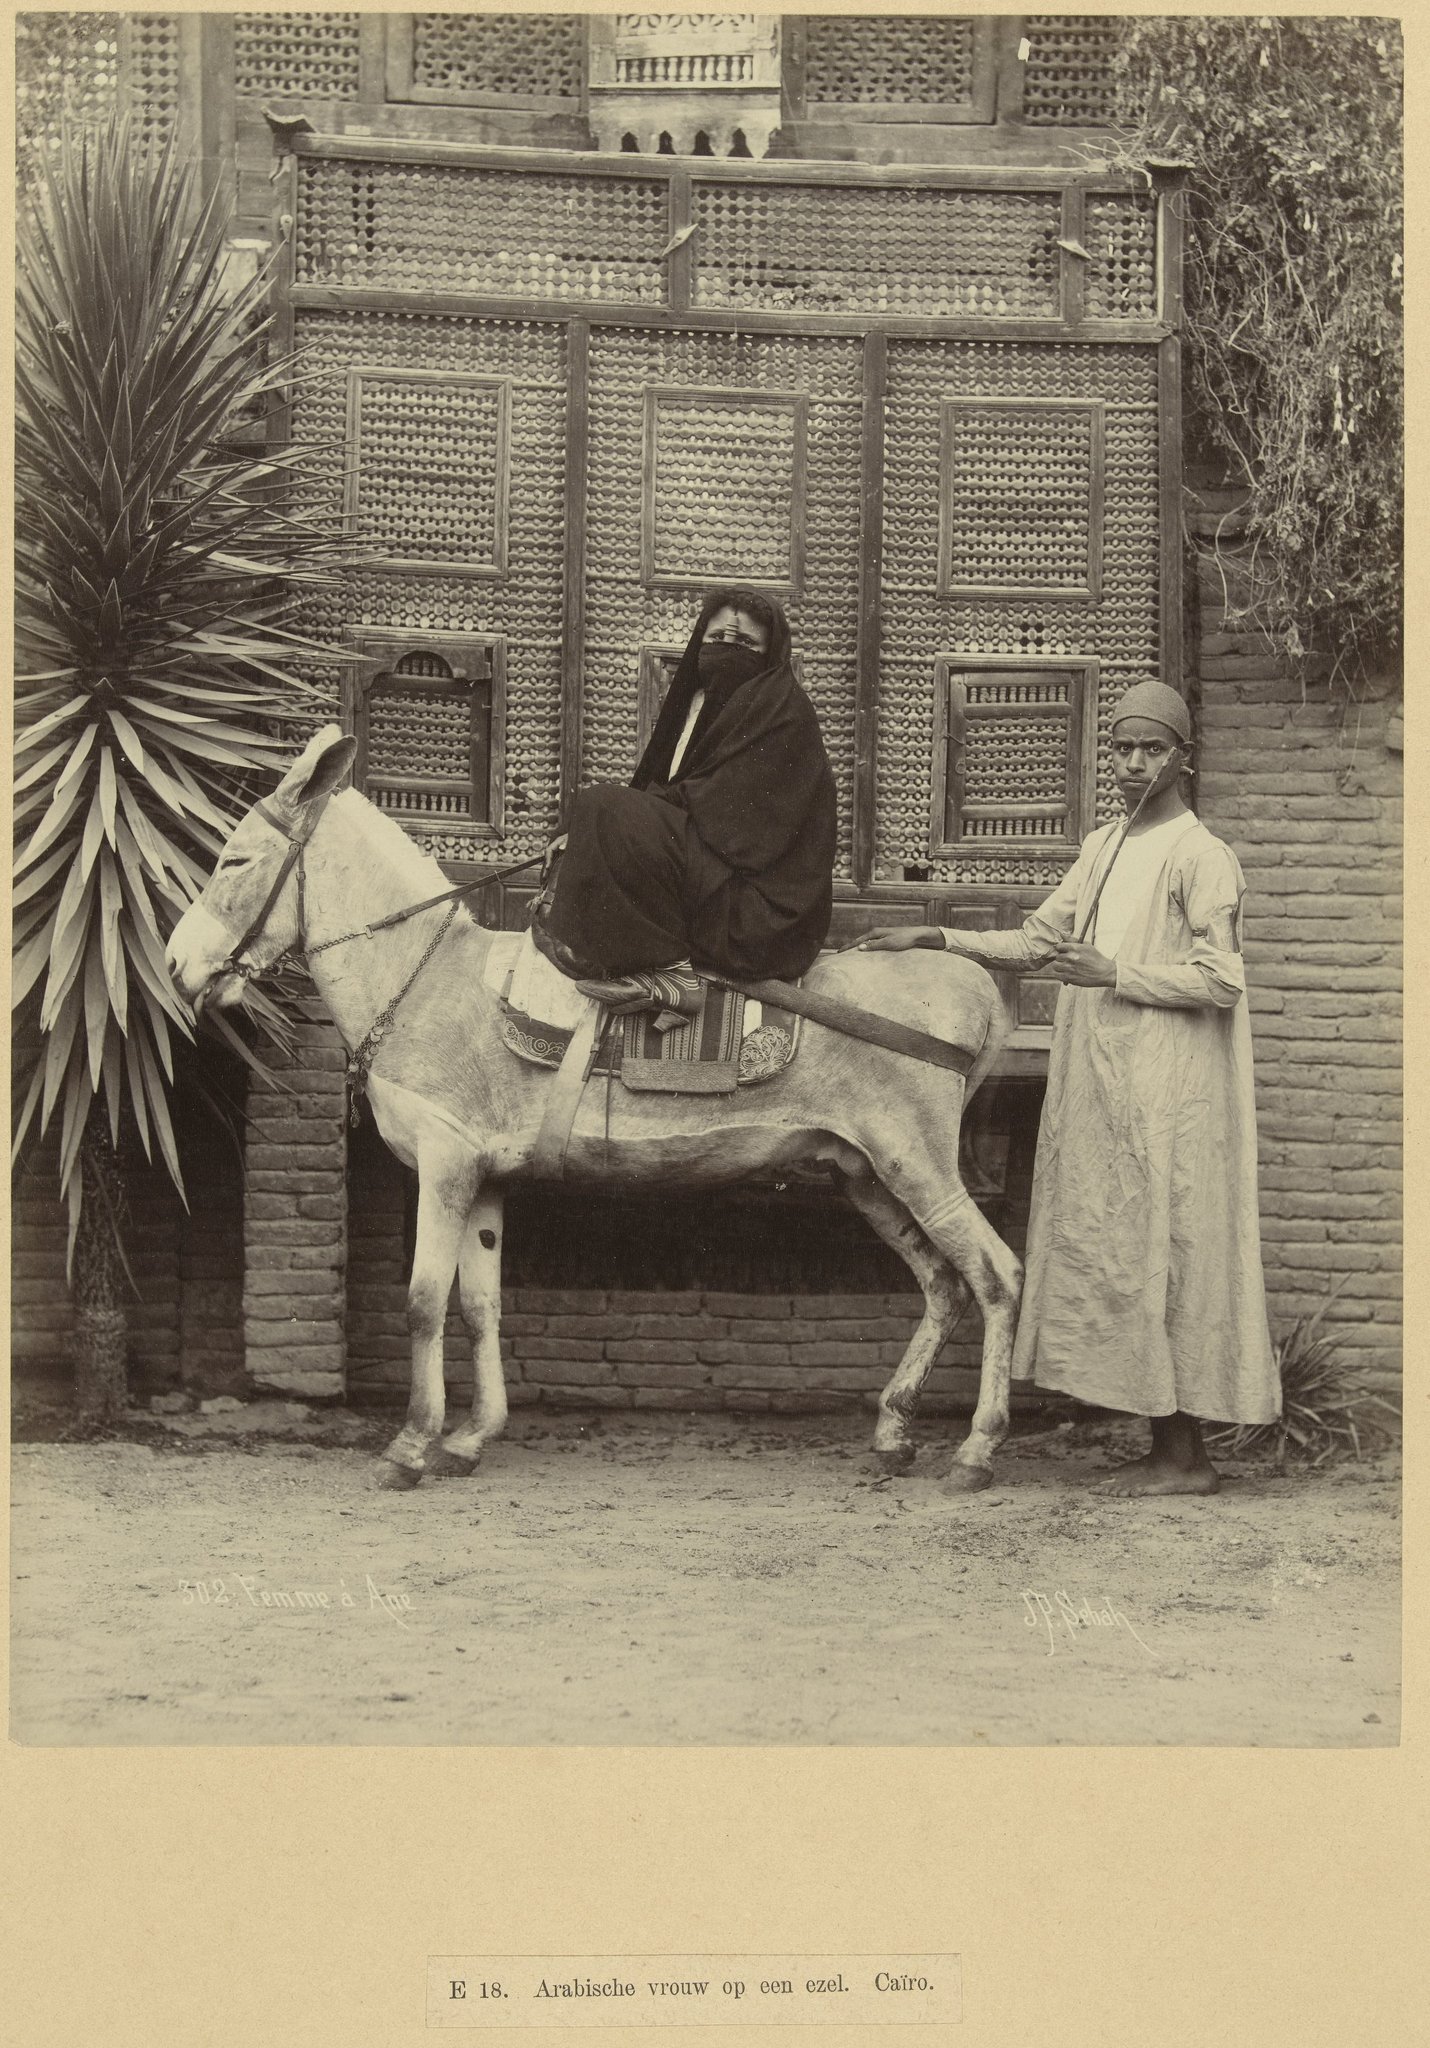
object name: photograph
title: E 18. Arabische vrouw op een ezel. Caïro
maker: jean pascal sébah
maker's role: fotograaf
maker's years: 1872-1947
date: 1888-1895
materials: cardboard, paper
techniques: albumen print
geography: cairo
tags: riding a horse, ass, or mule; rider, horseman, ass, donkey, historical persons not known by name - bb - woman, historical persons not known by name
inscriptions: number: ‘302’, title: ‘E 18. Arabische vrouw op een ezel. Caïro.’, stamp: ‘Gemeentelijke bibliotheek/ Rotterdam’, check stamp: ‘Bristol/ L.M.’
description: Onderdeel van een groep door fotograaf Richard Polak op reis verzamelde foto’s. Deze foto is samen met andere op zijn reizen verzamelde foto's tentoongesteld bij de Rotterdamsche Kunstkring (1895), Arti en Amicitiae te Amsterdam (1897-1898?) en Societeit 't Collegie te Kampen (datum vooralsnog onbekend).